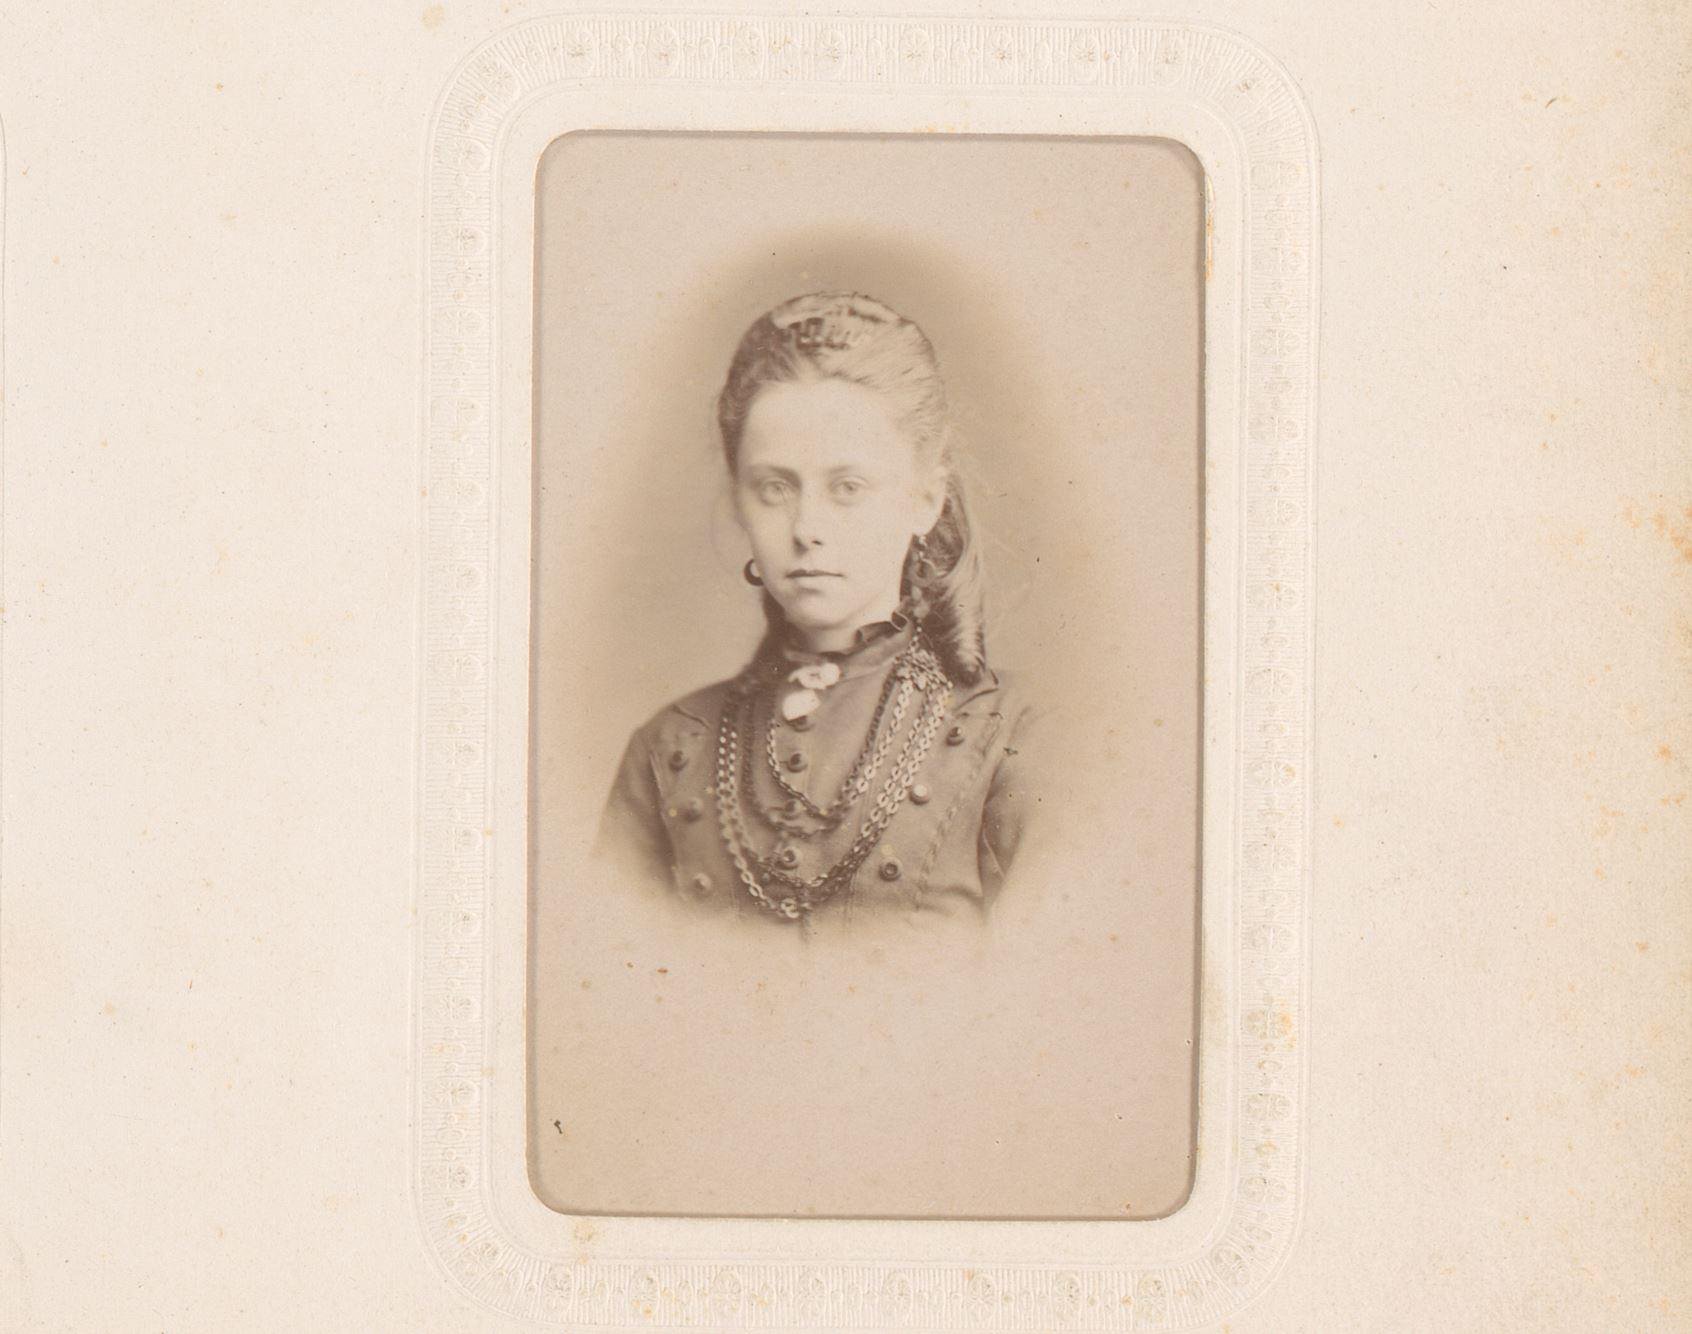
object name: photograph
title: Portret van een meisje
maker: Anonymous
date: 1860-1900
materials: cardboard, photographic support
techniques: albumen print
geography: netherlands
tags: historical persons - bb - woman, girl (child between toddler and youth)